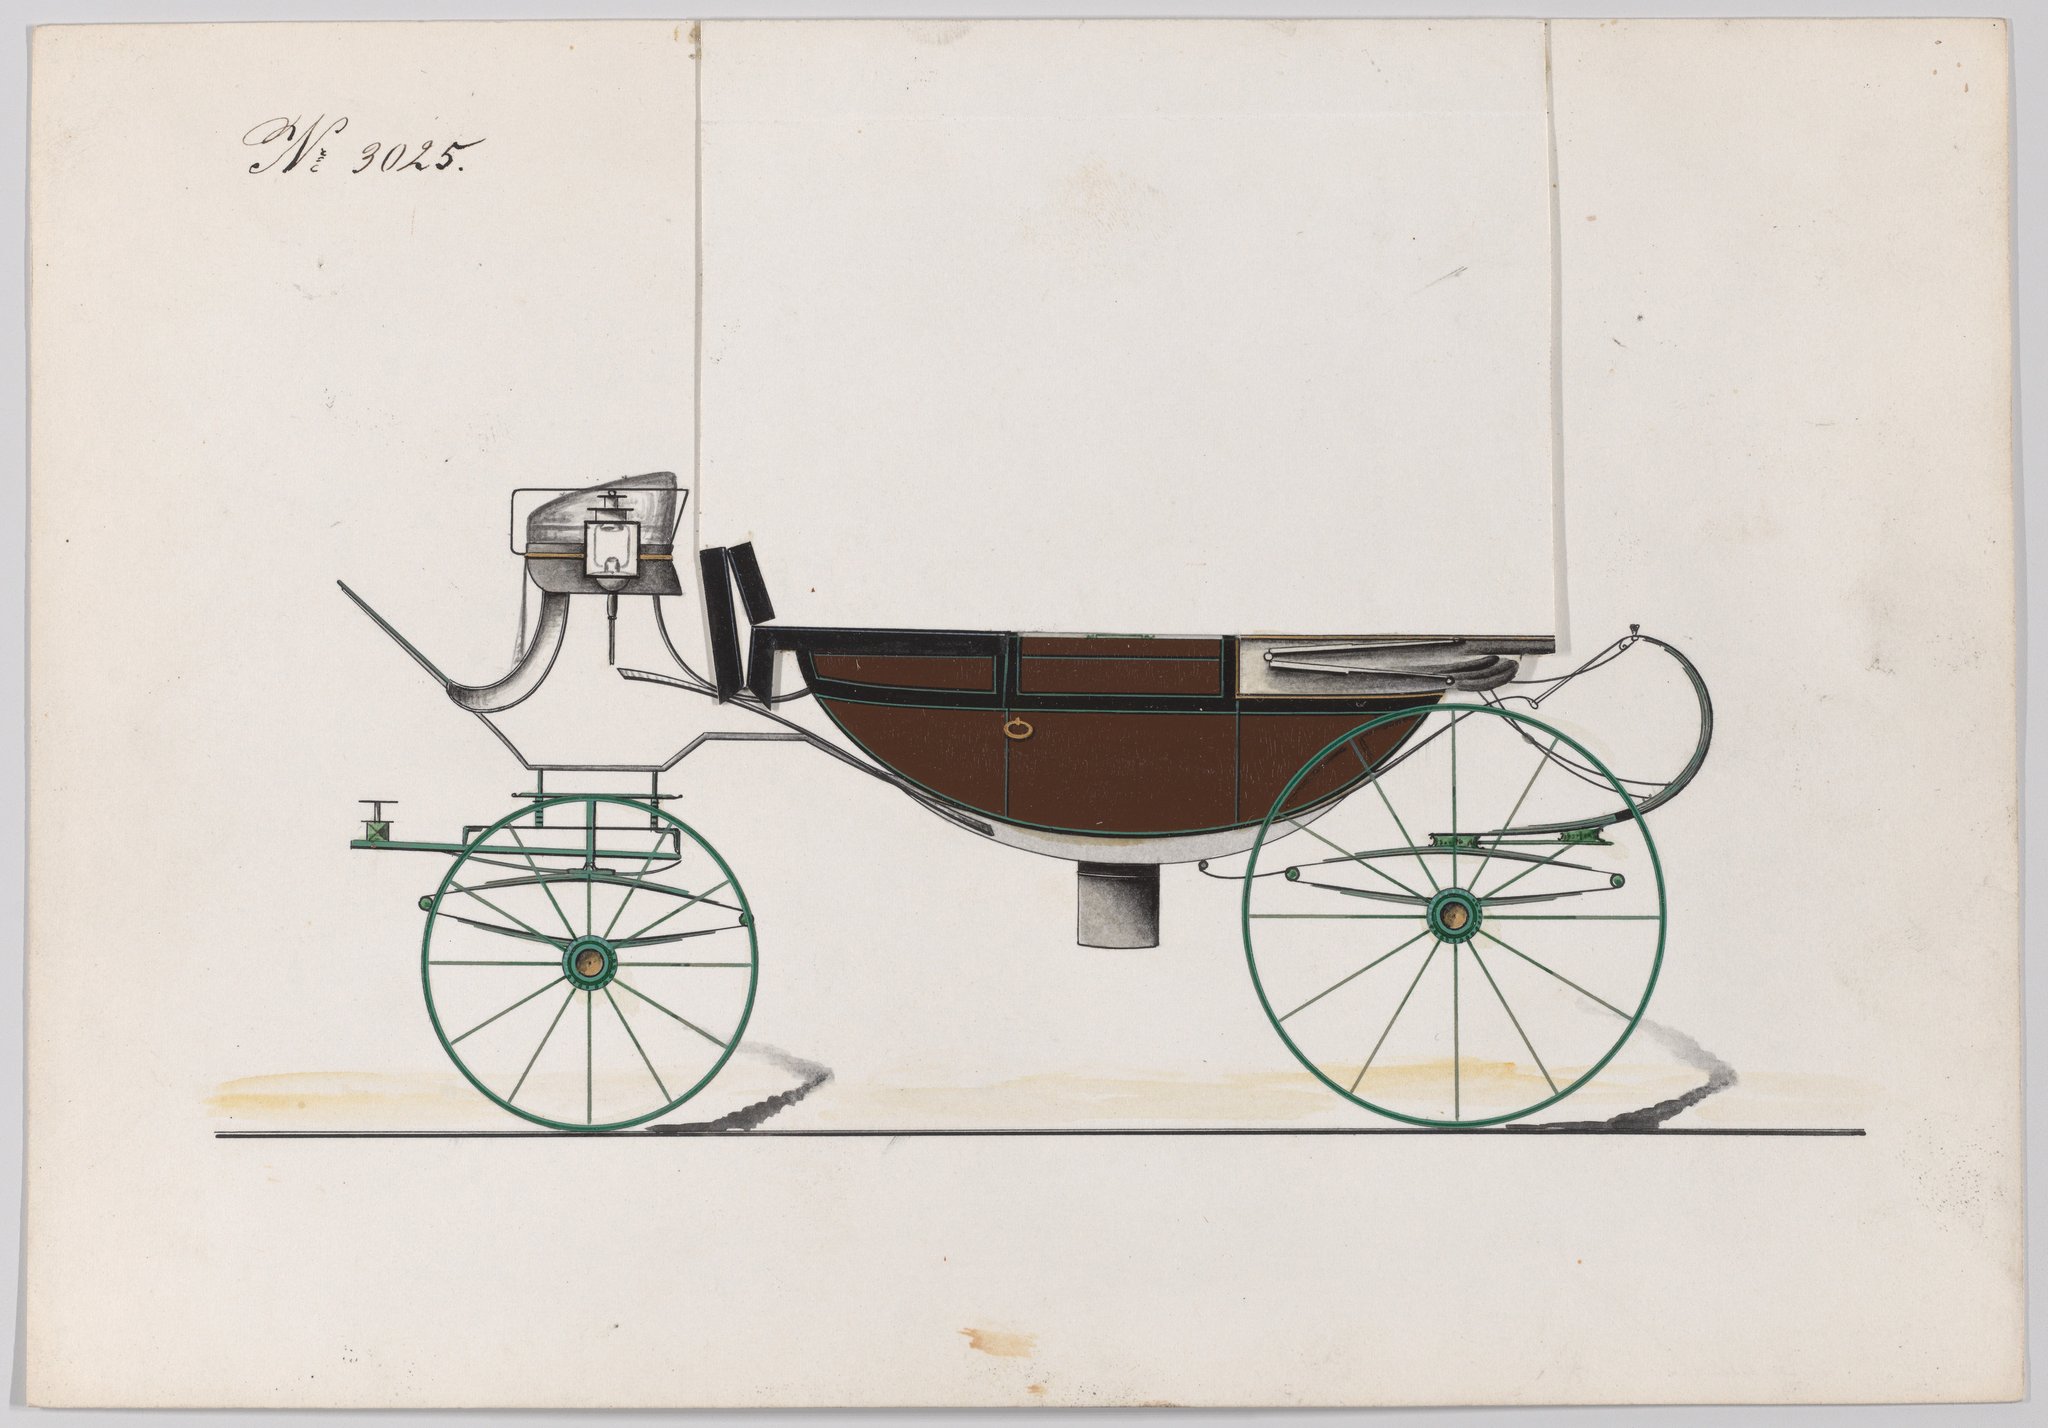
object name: drawing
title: Design for Landau, No. 3025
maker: brewster & co.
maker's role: manufacturer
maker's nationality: american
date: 1878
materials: gouache, gum arabic, ink, watercolor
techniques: pen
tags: carriages